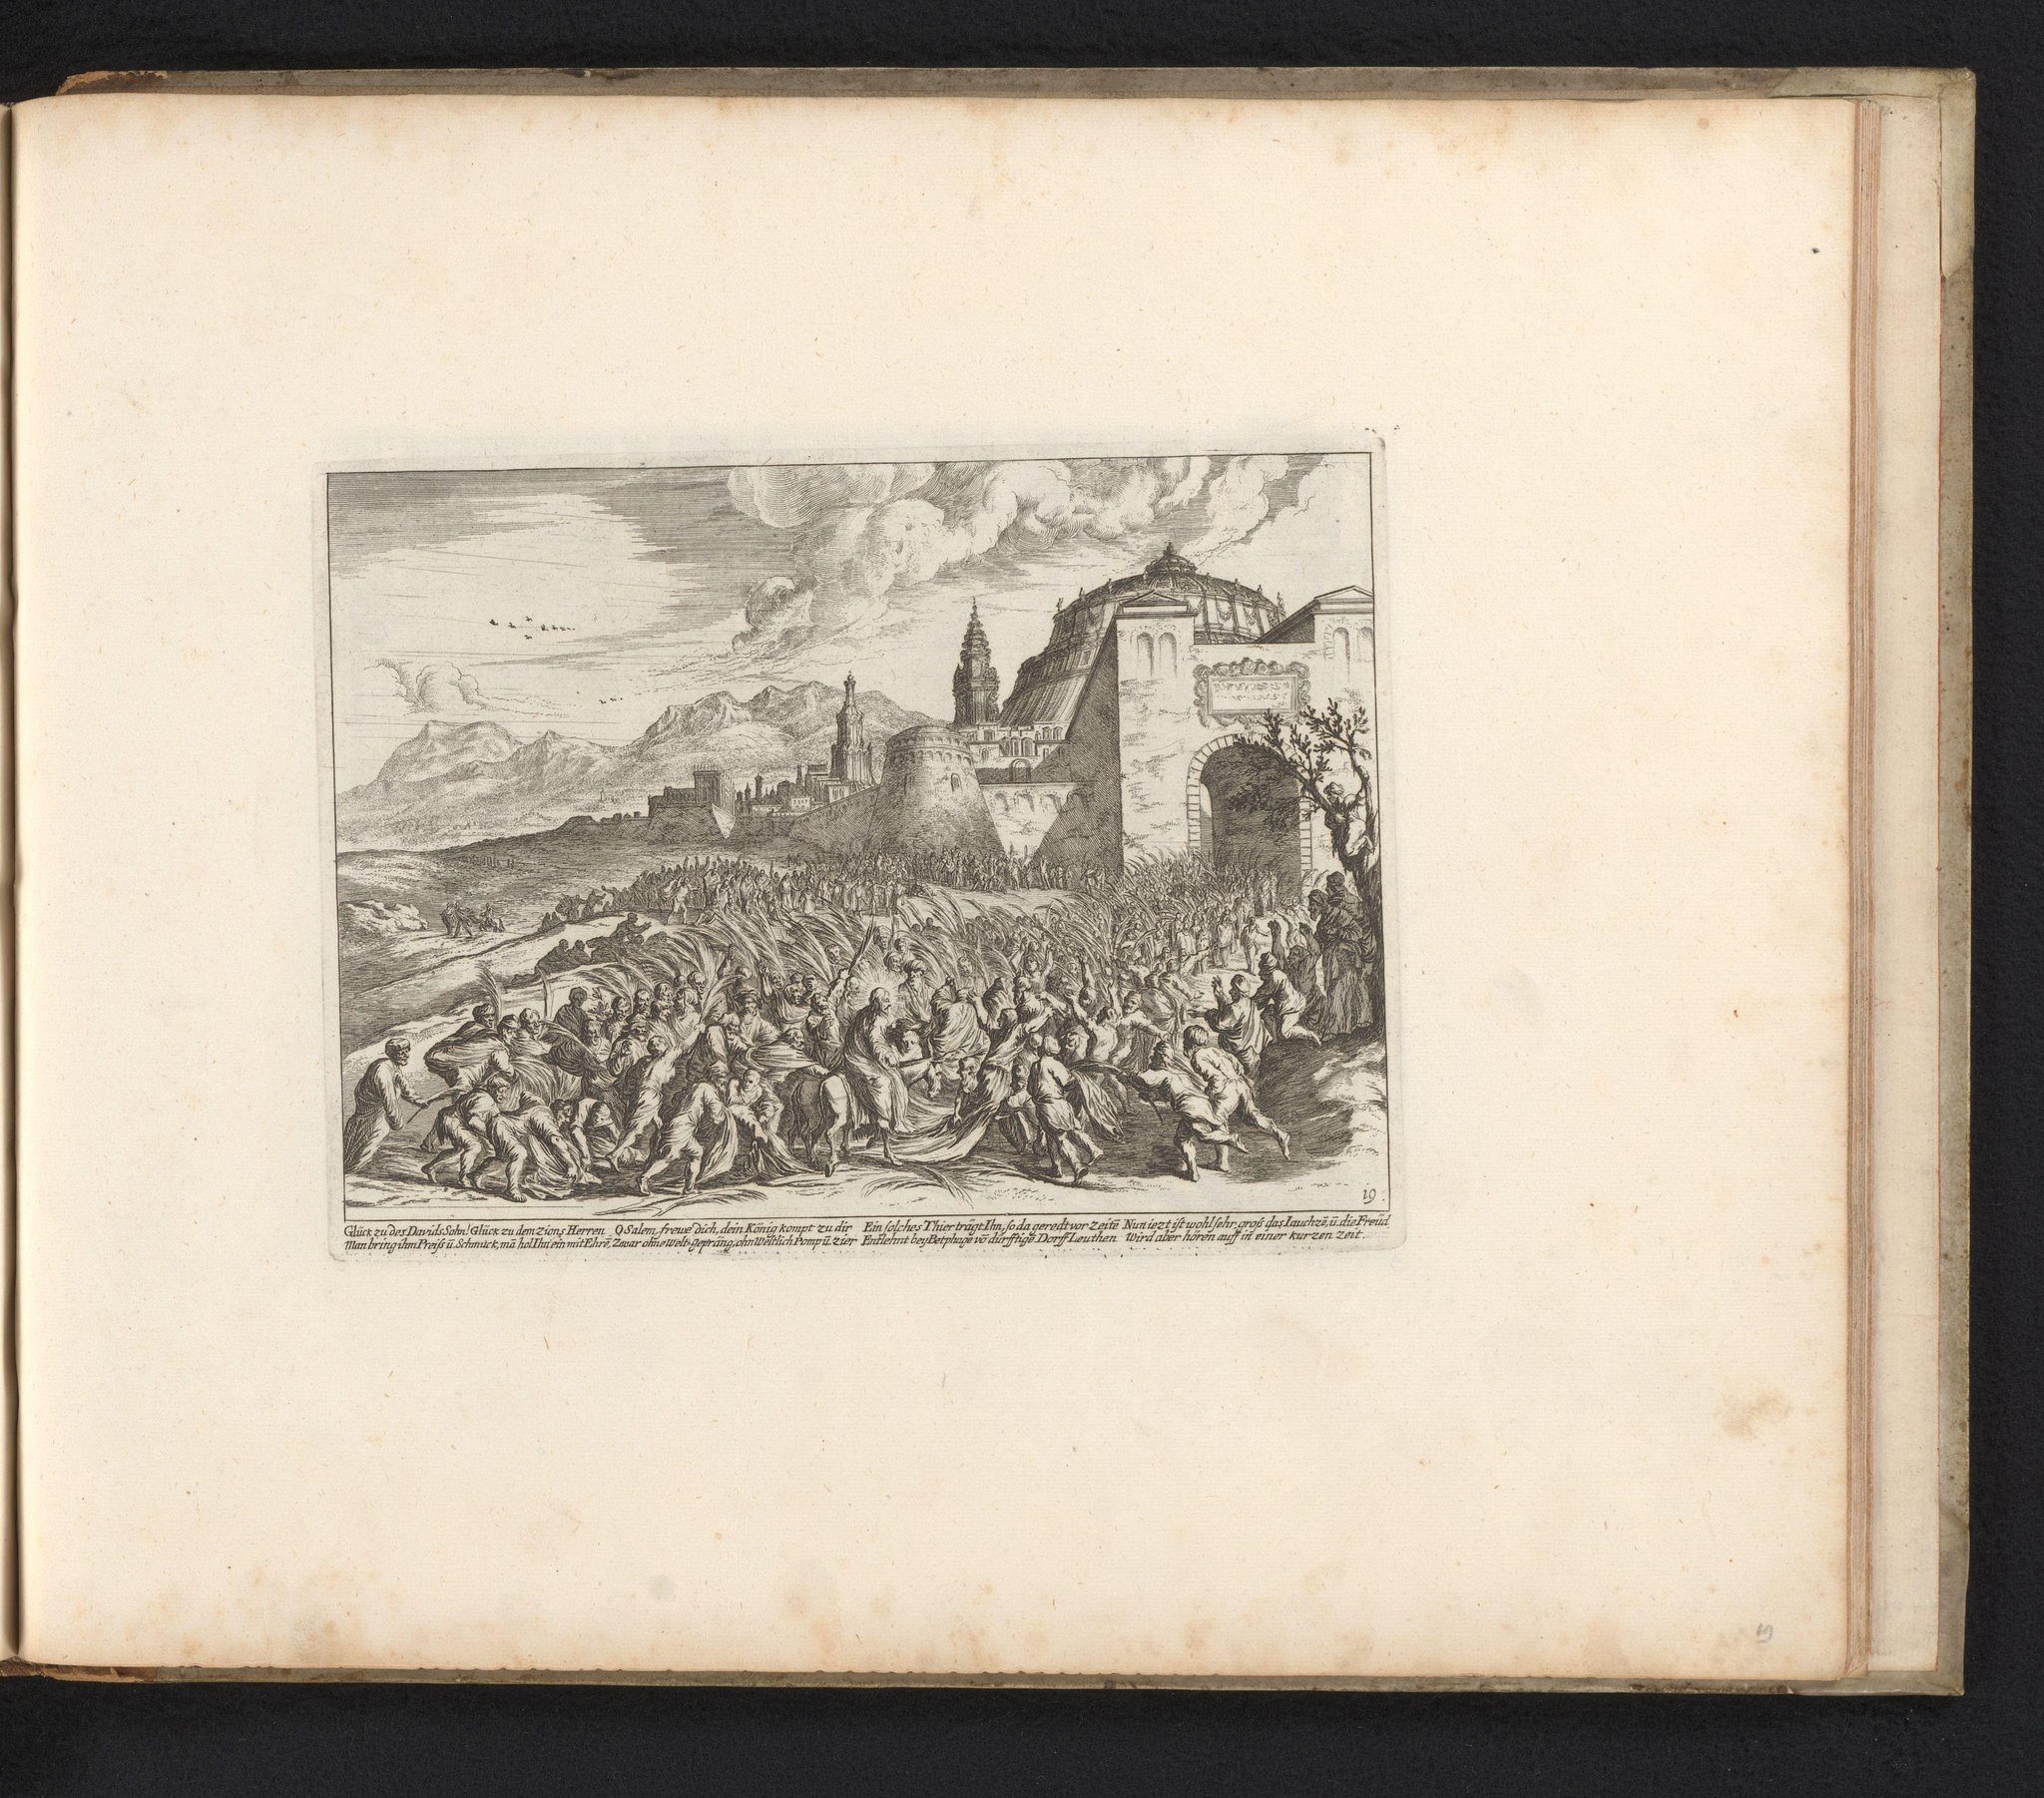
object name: print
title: Intocht in Jeruzalem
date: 1670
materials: paper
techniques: etching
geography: augsburg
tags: palm sunday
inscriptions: collector's mark: Lugt 2228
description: Tekst in het Duits in de ondermarge. Rechtsonder genummerd: 19. Prent maakt deel uit van een album.